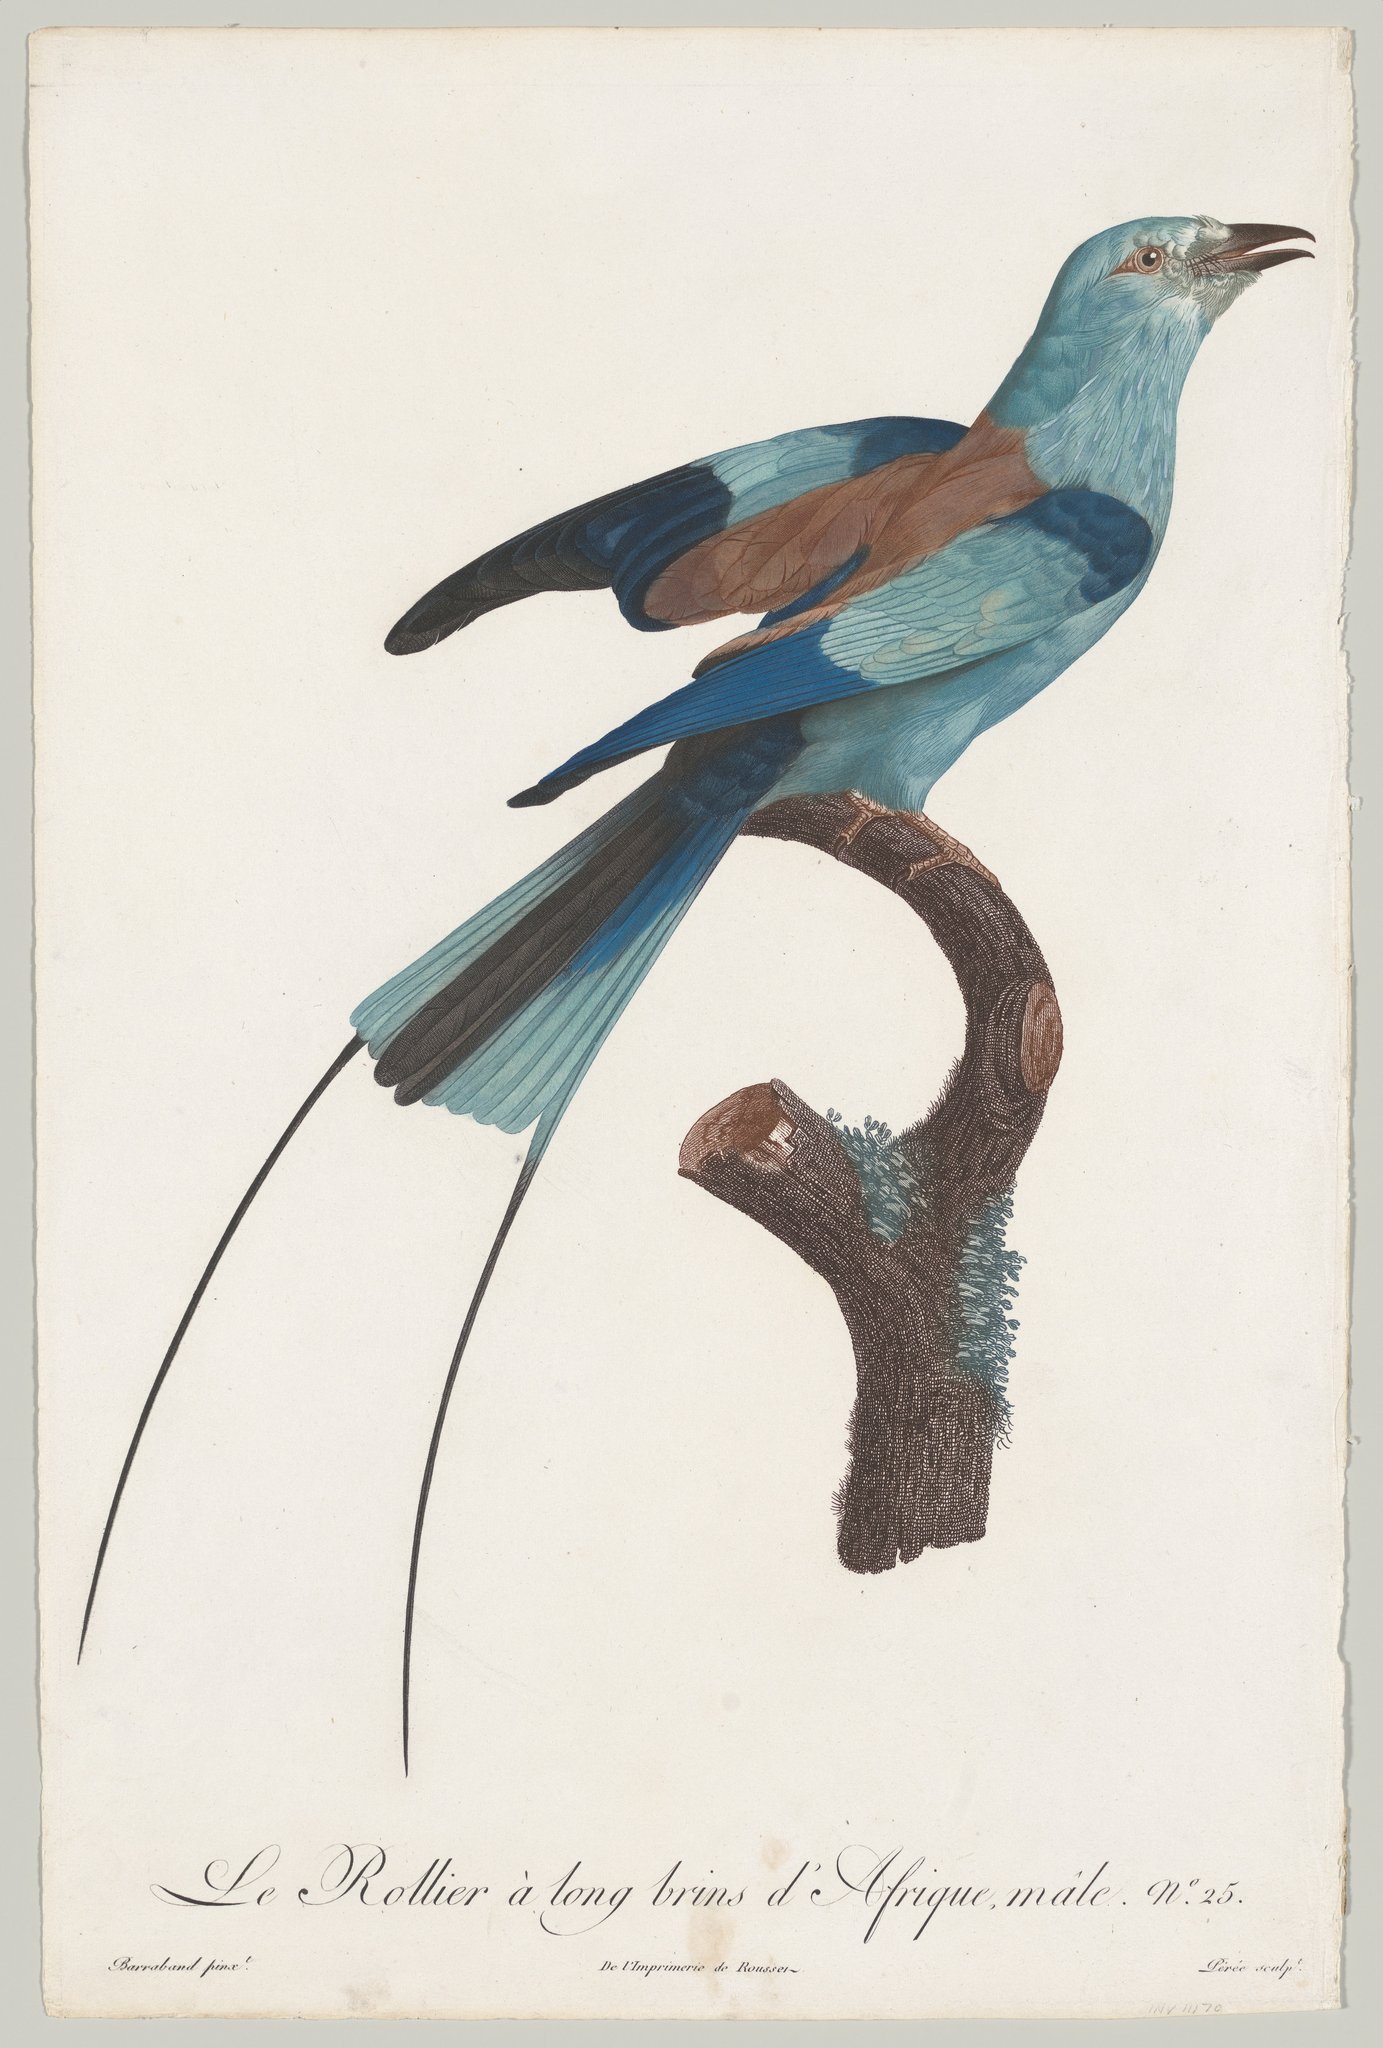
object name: print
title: Plate 25, from "Histoire naturelle des perroquets"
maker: françois levaillant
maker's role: artist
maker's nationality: french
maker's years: 1753-1824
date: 1801-1806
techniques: engraving, hand coloring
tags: birds